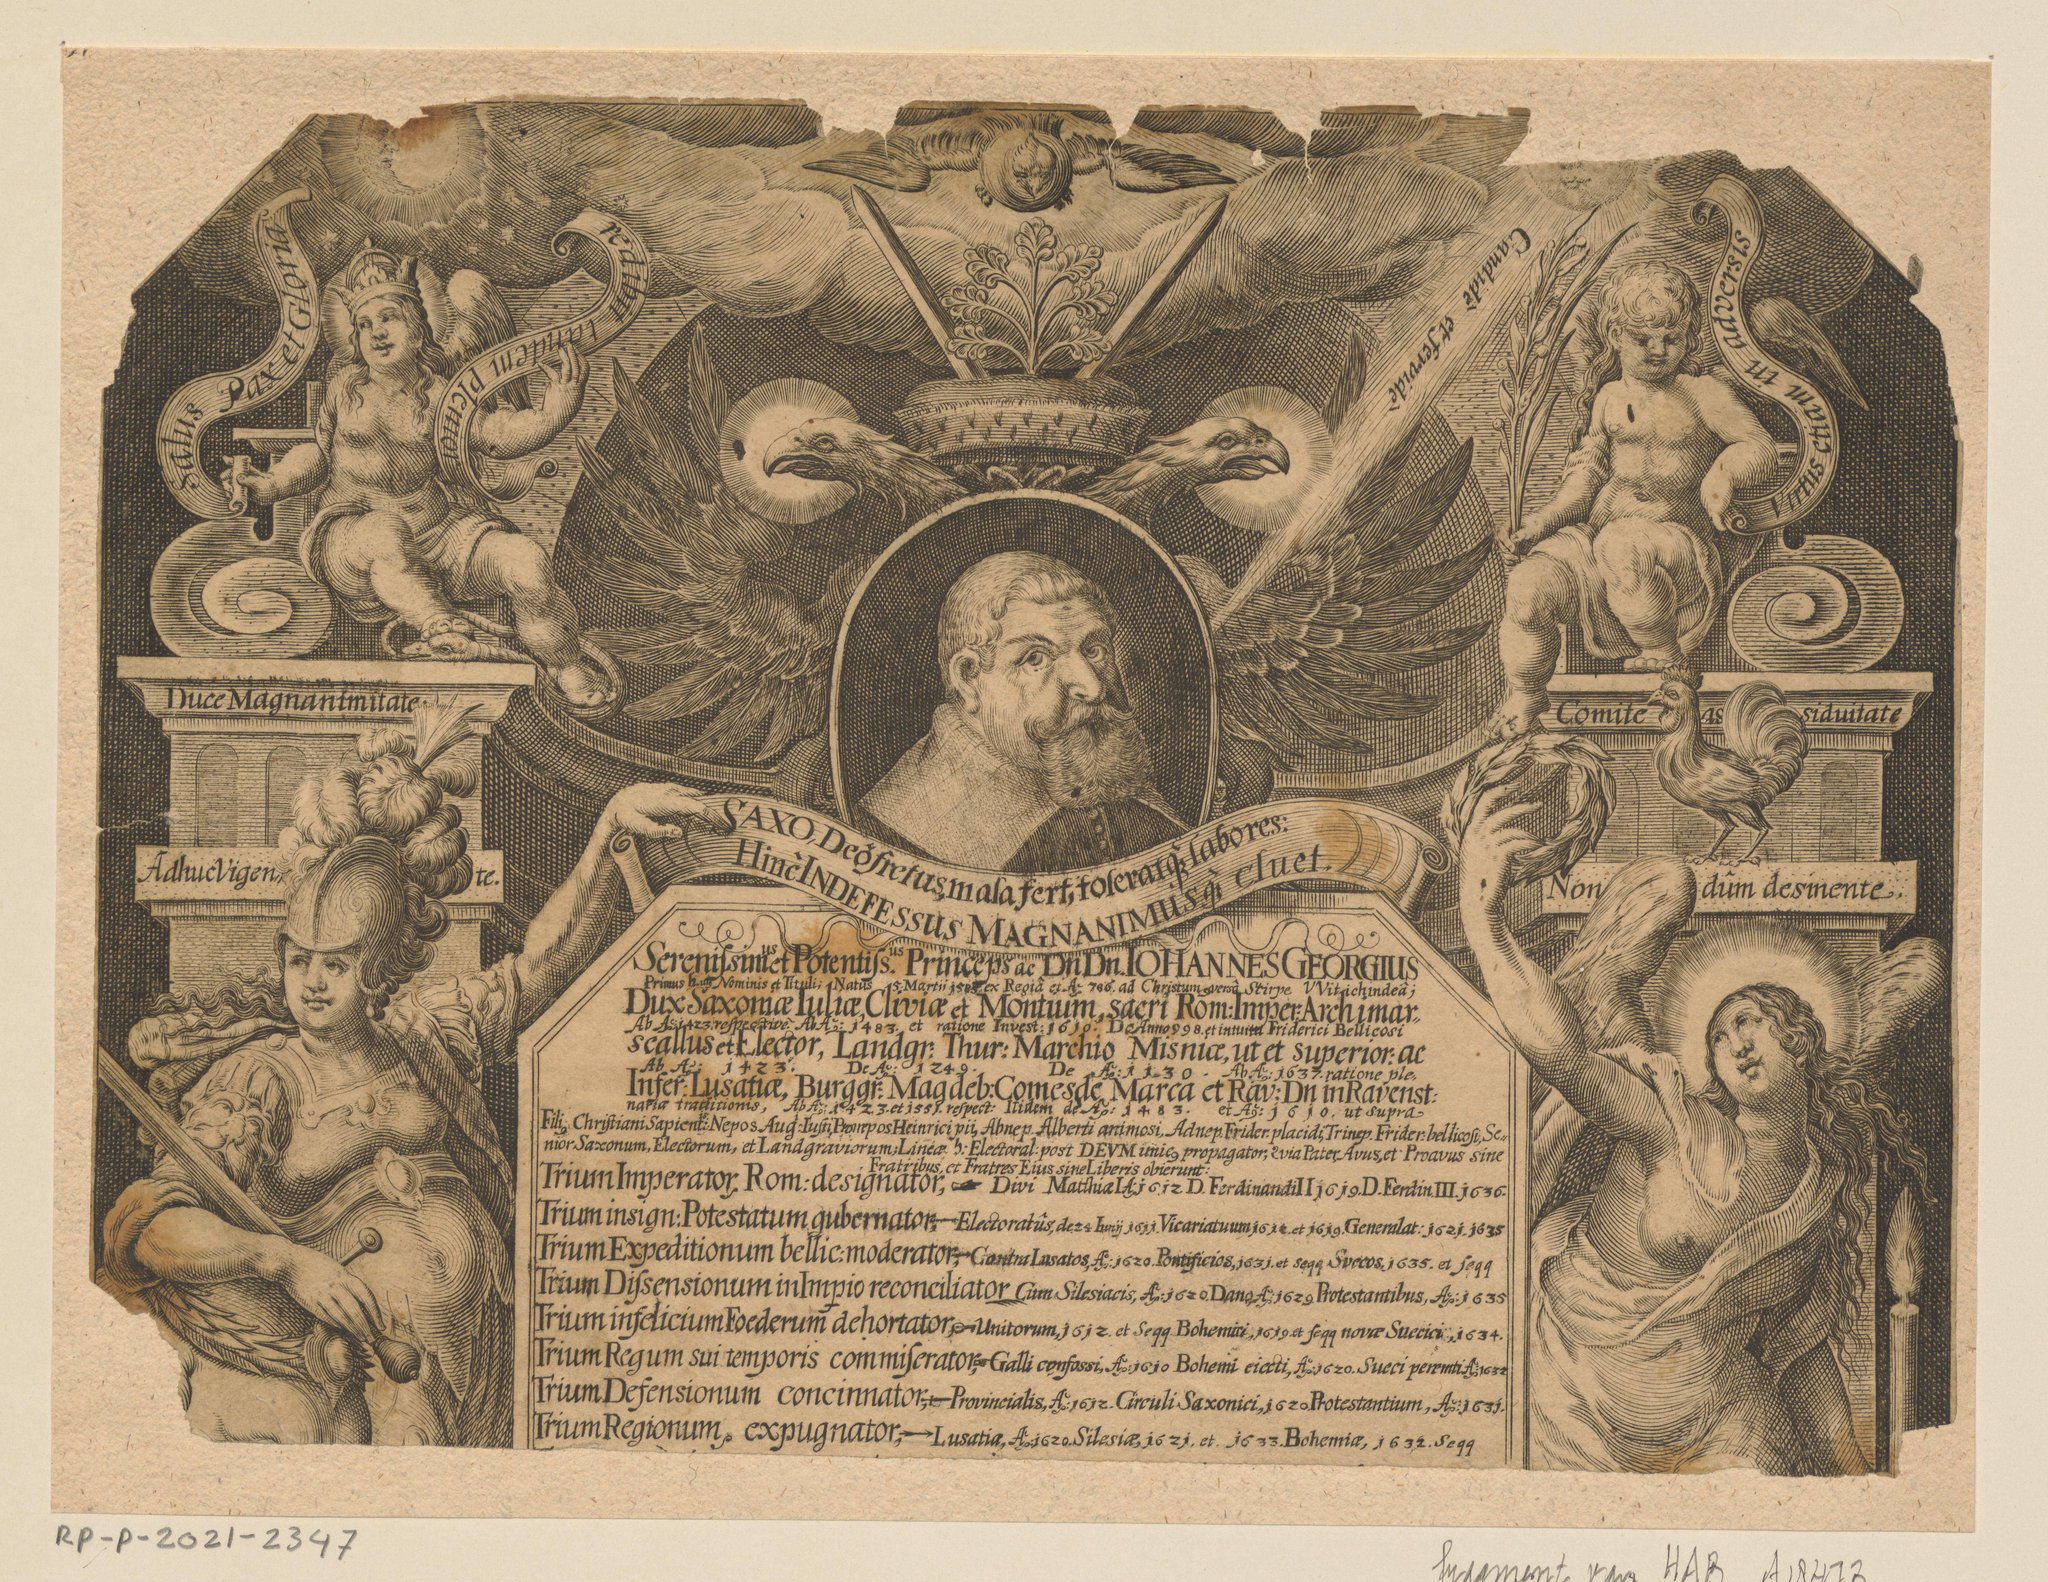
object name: print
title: Allegorische voorstelling met portret van Johann George I van Saksen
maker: nicolaus weishun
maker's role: print maker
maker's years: 1607-1687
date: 1641-1687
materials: paper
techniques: engraving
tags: johann george van saksen (i), predatory birds: eagle, historical persons, ruler, sovereign, cupids: 'amores', 'amoretti', 'putti', holy ghost represented as a dove (in flames)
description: Deze prent maakt deel uit van een grotere prent waarvan het onderste deel later is weggesneden.